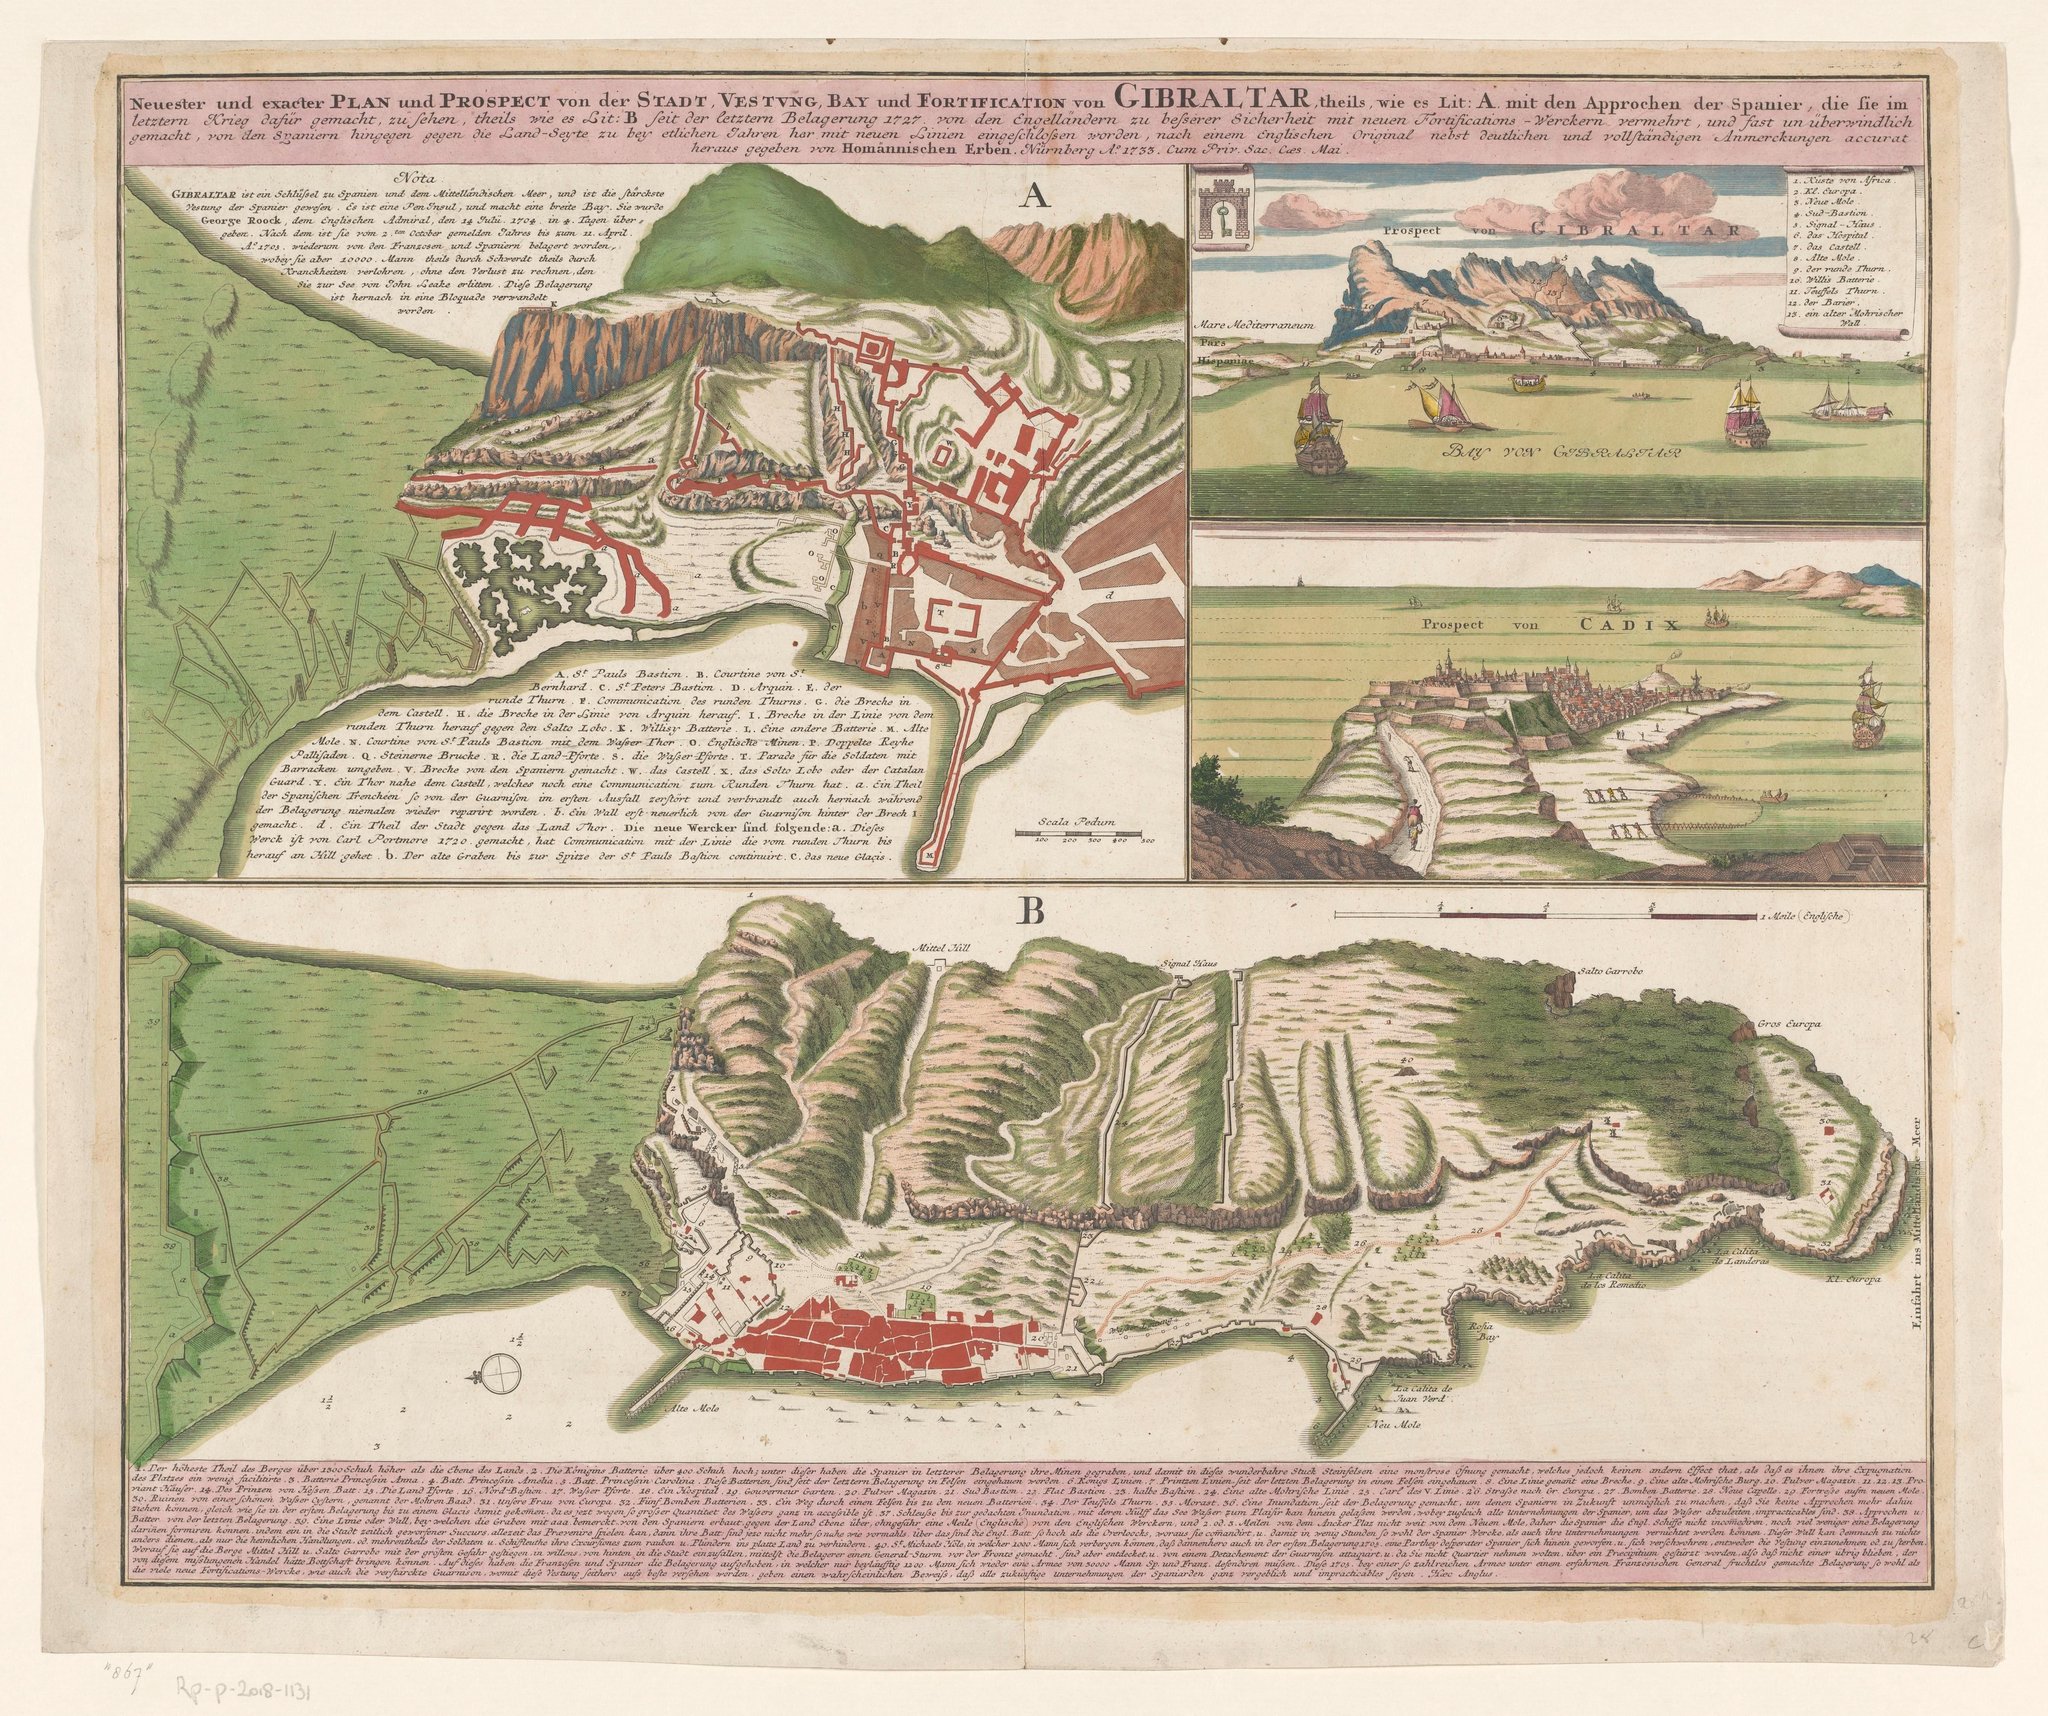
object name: area plan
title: Plattegronden van Gibraltar met gezichten op de vesting en baai van Gibraltar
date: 1733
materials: paper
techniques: engraving, etching, hand coloring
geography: nuremberg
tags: gulf, bay, prospect of city, town panorama, silhouette of city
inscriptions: collector's mark: Lugt 2228